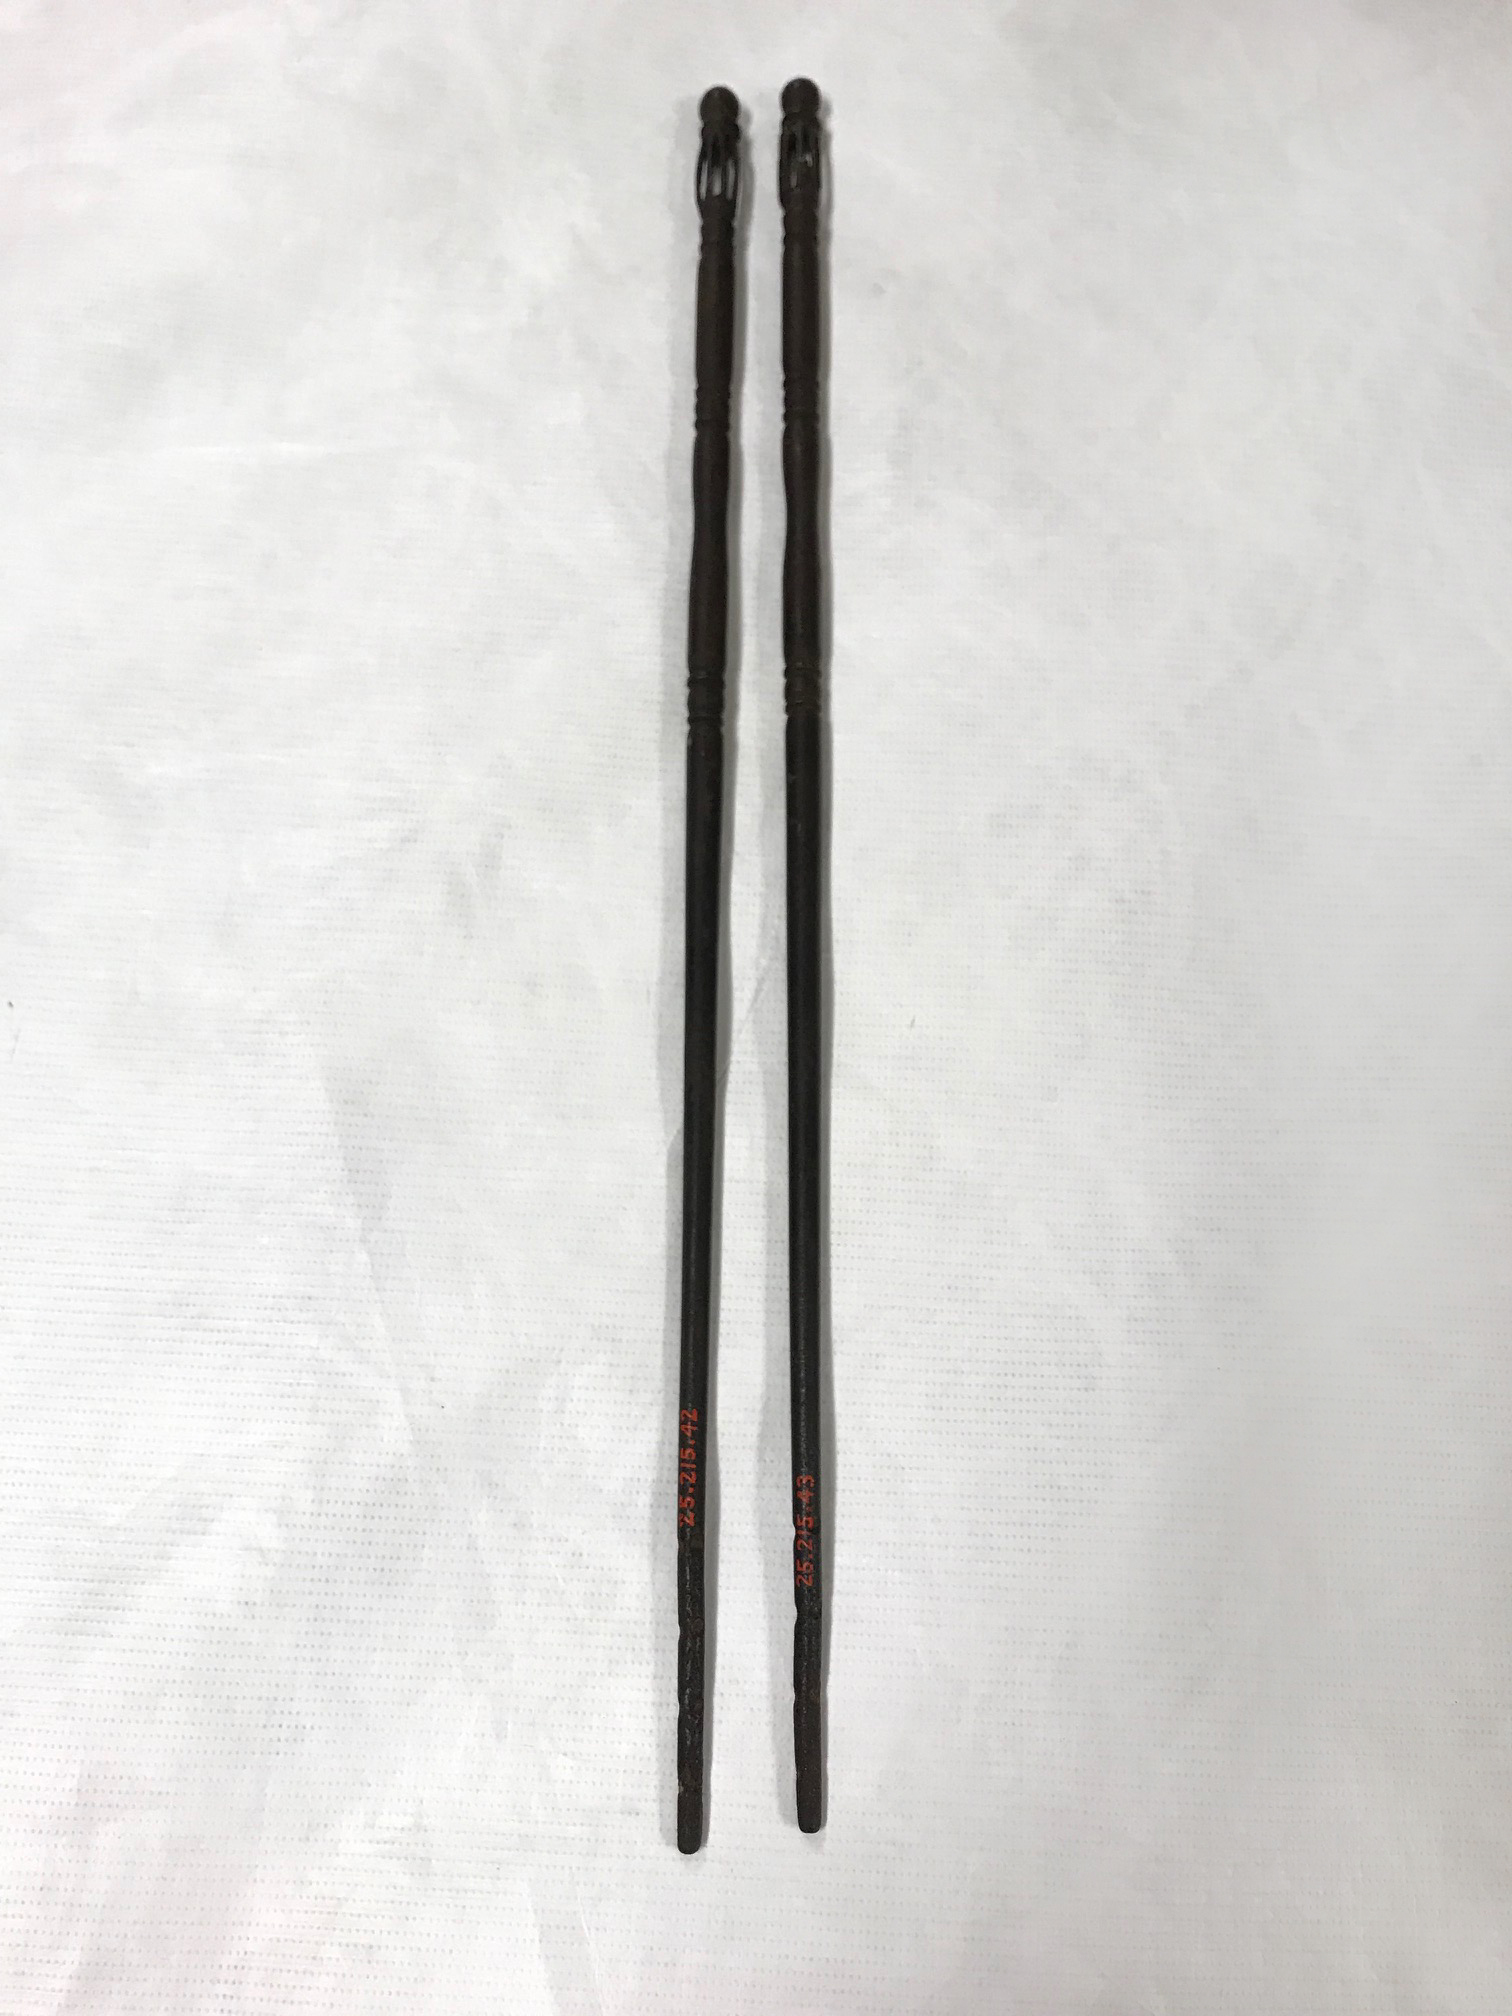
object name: fire tong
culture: japanese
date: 1775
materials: iron